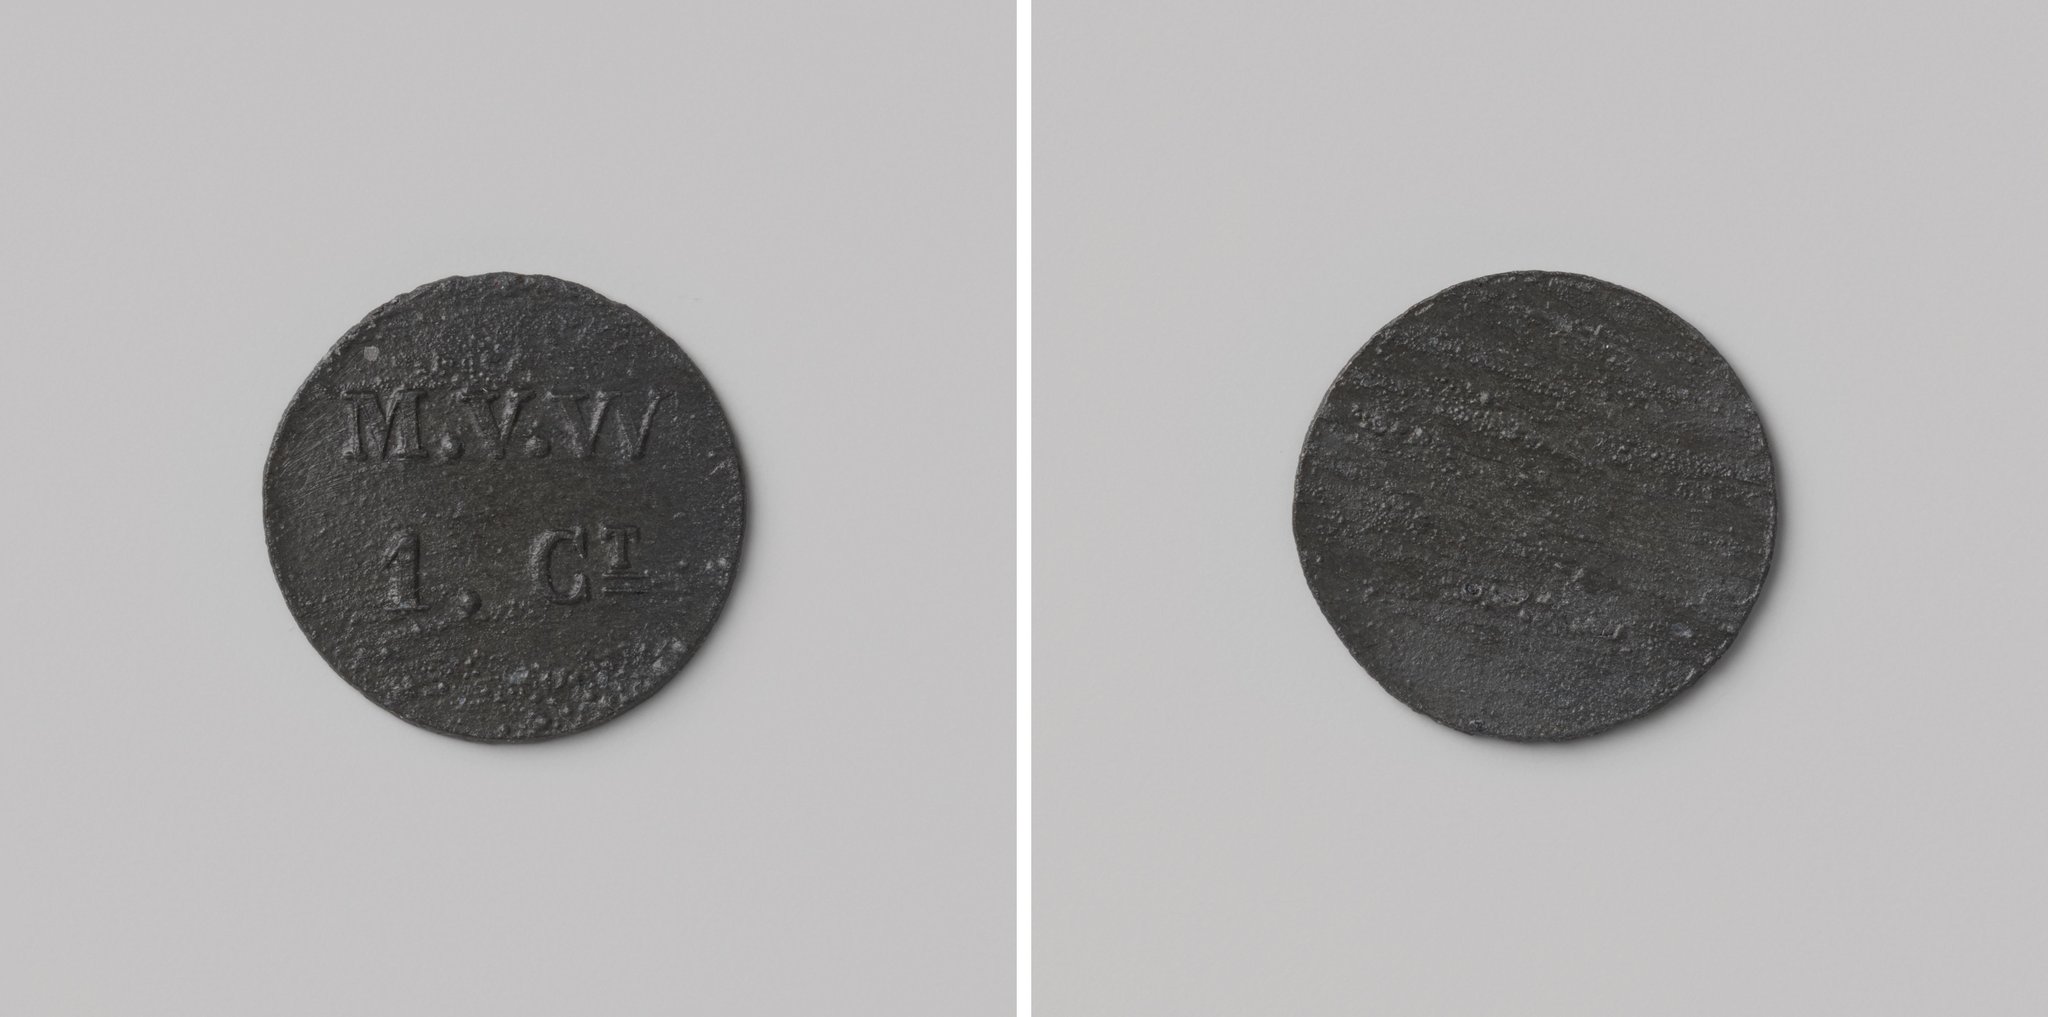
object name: monetary token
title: Huismunt geslagen op last van de Maatschappij van Weldadigheid ter waarde van 1 cent, ten behoeve van de Gewone Koloniën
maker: Anonymous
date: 1818-1859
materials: zinc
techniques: striking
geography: netherlands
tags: maatschappij van weldadigheid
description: Eenzijdige zinken munt. Voorzijde: opschrift boven waardeaanduiding. Keerzijde: blanco